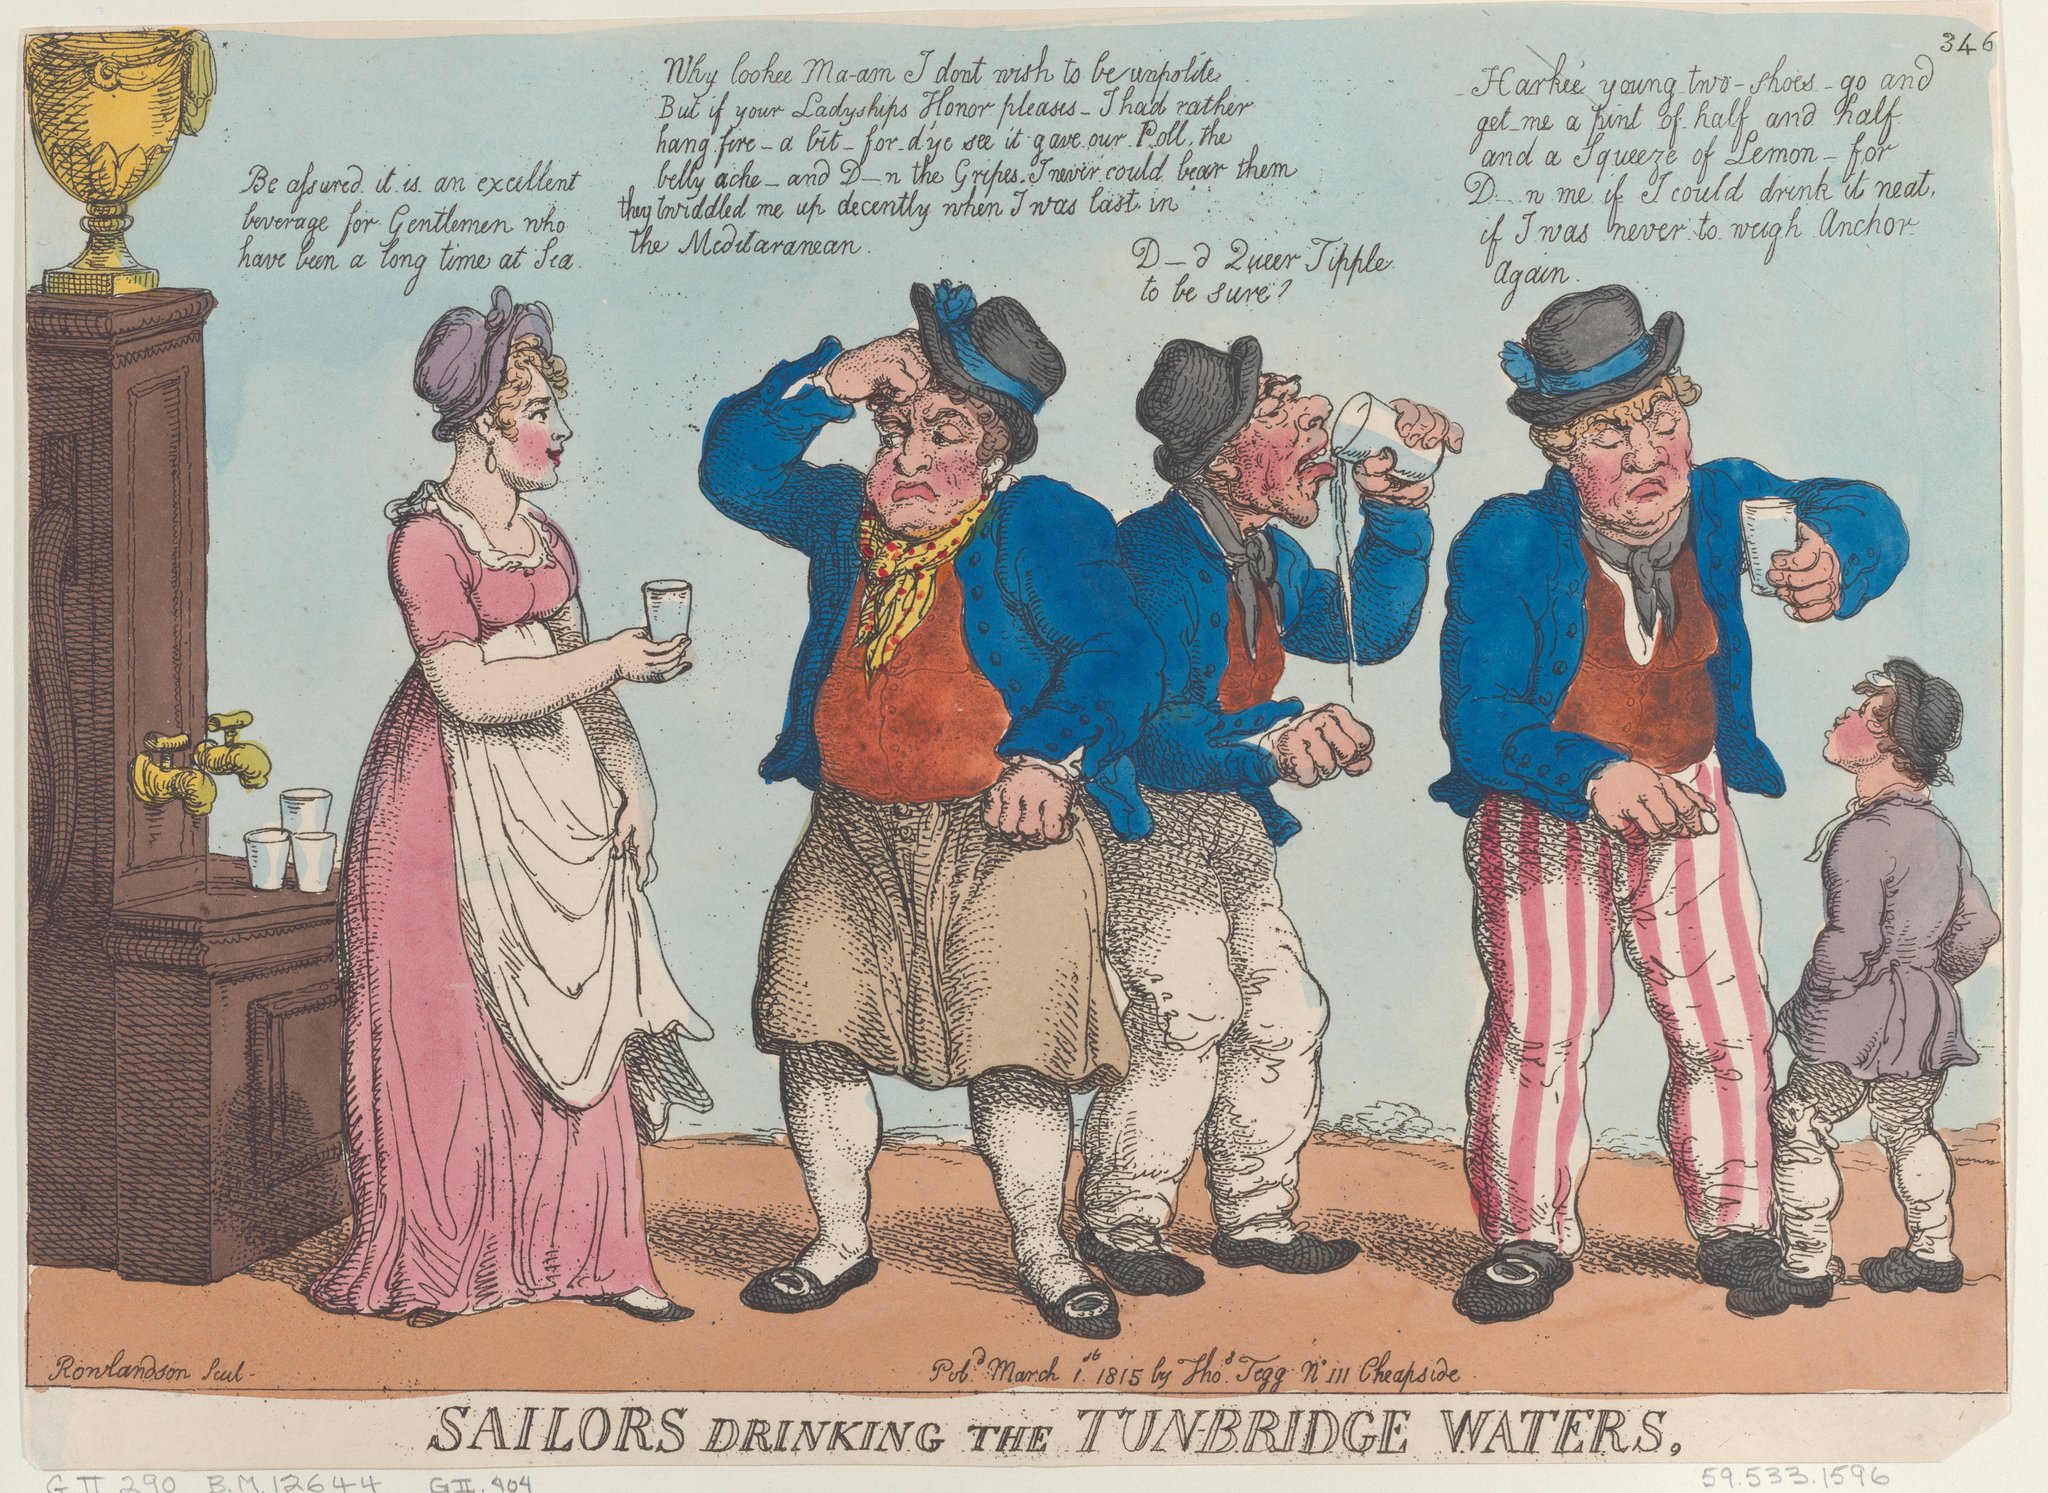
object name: print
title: Sailors Drinking the Tunbridge Waters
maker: thomas rowlandson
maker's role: artist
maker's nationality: british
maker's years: 1757-1827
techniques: etching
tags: satire,men,women,drinking